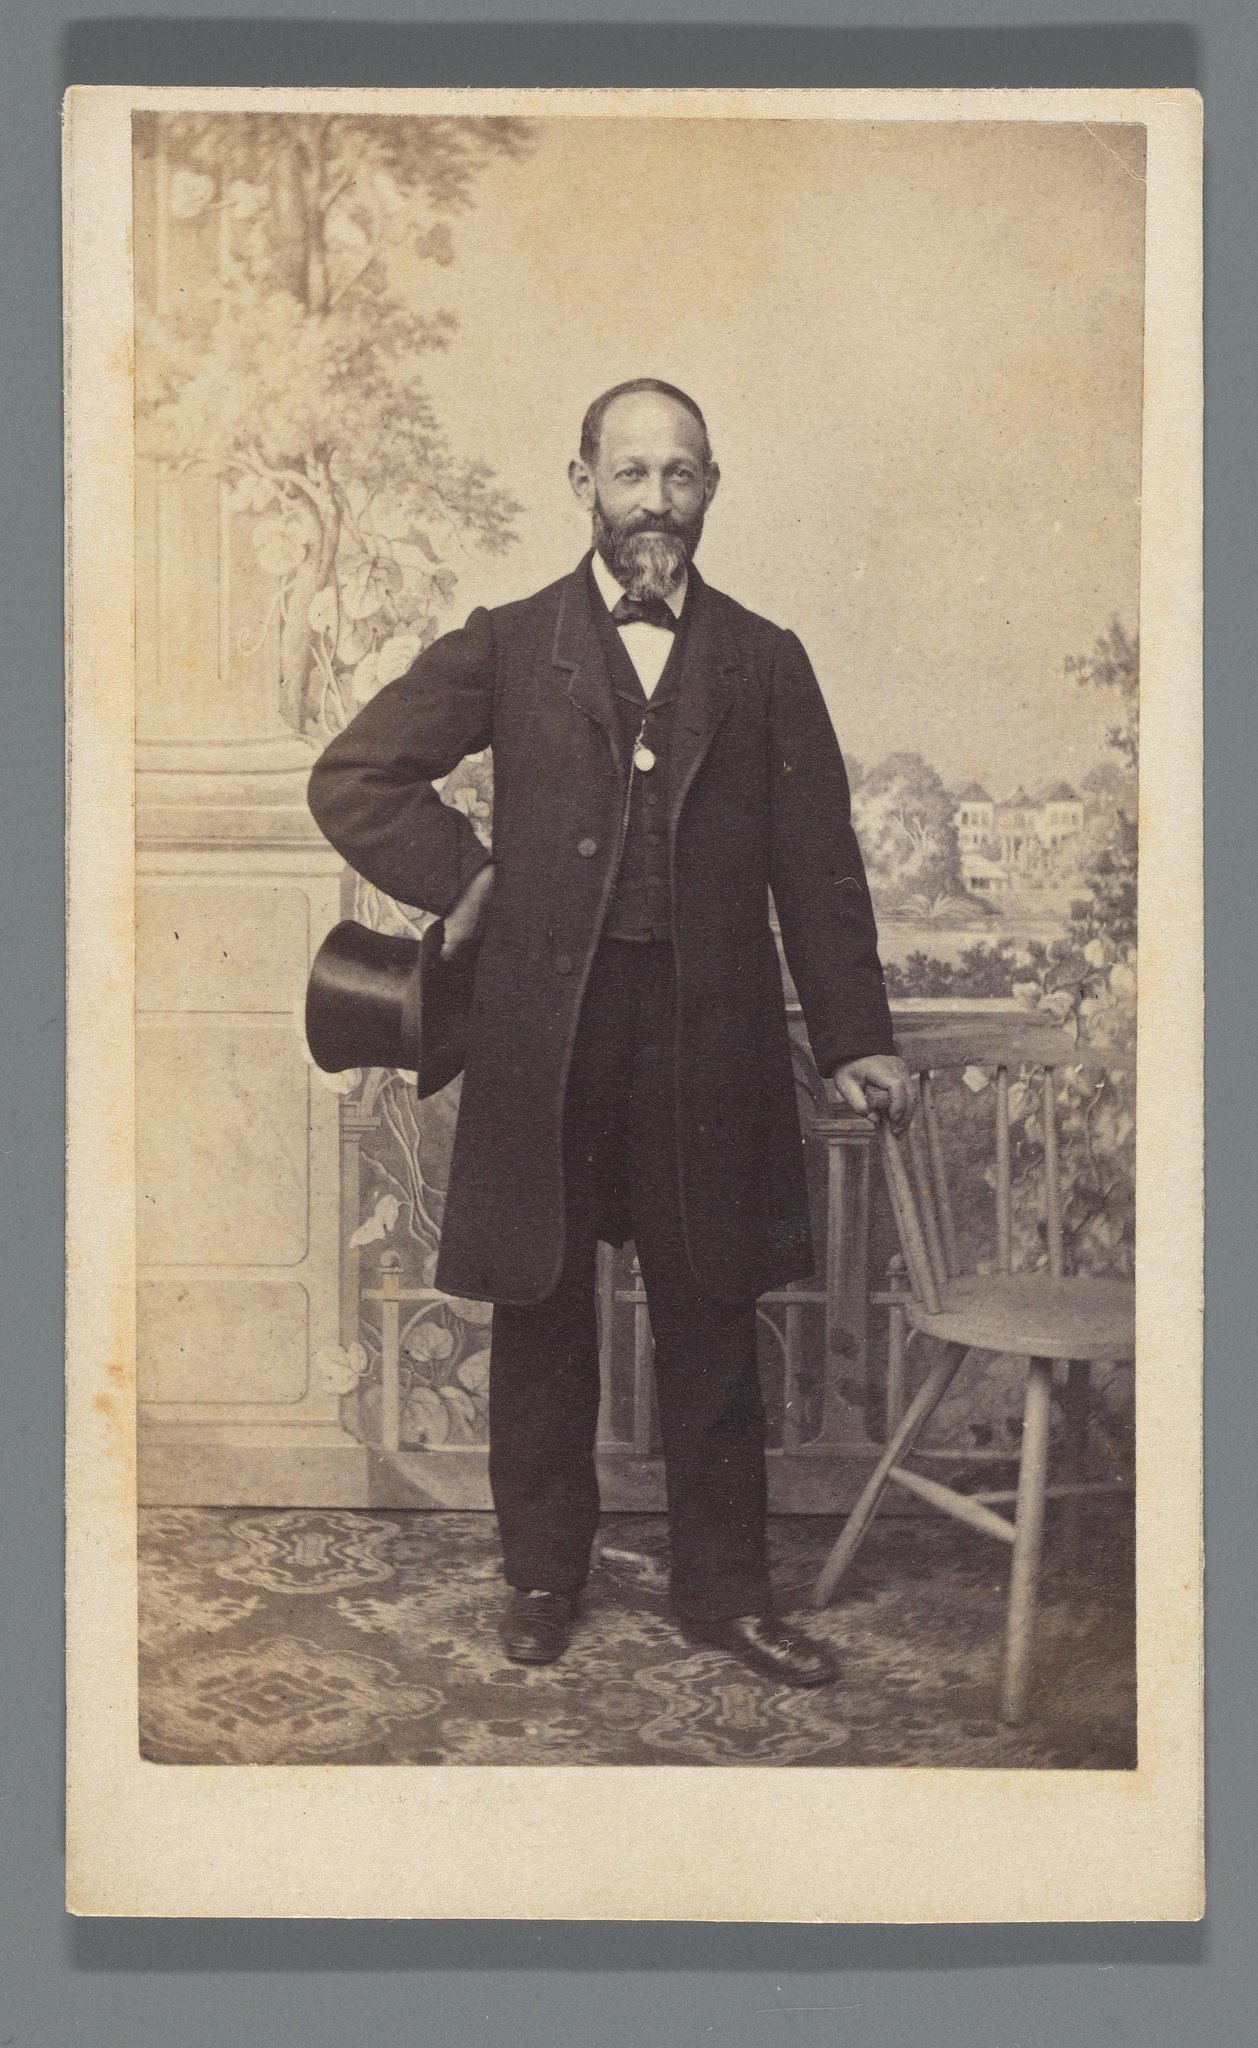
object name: carte de visite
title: Portret van de arts Friedrich Julius Stiebel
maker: hermann hartmann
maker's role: fotograaf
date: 1865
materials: photographic support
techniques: albumen print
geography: frankfurt am main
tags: frankfurt, arts, friedrich julius stiebel